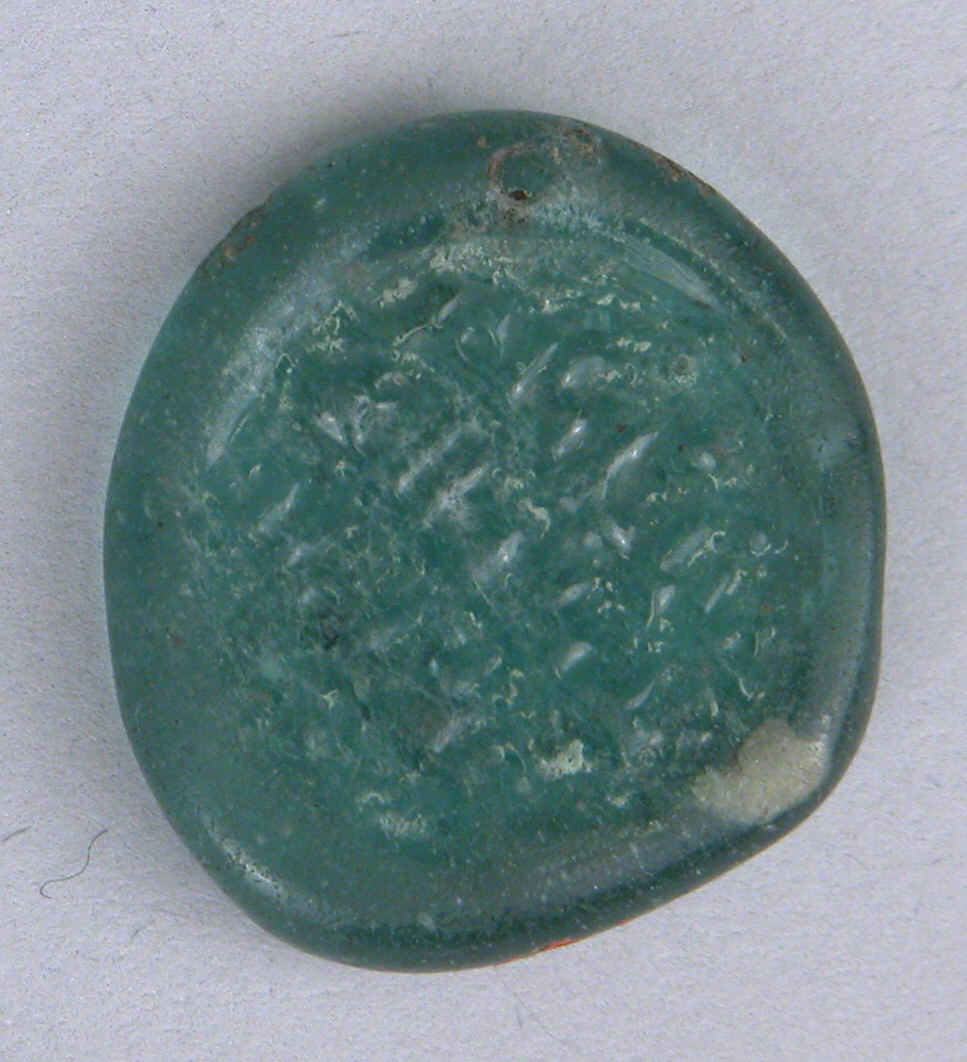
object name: coin weight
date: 1001-1100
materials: glass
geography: egypt